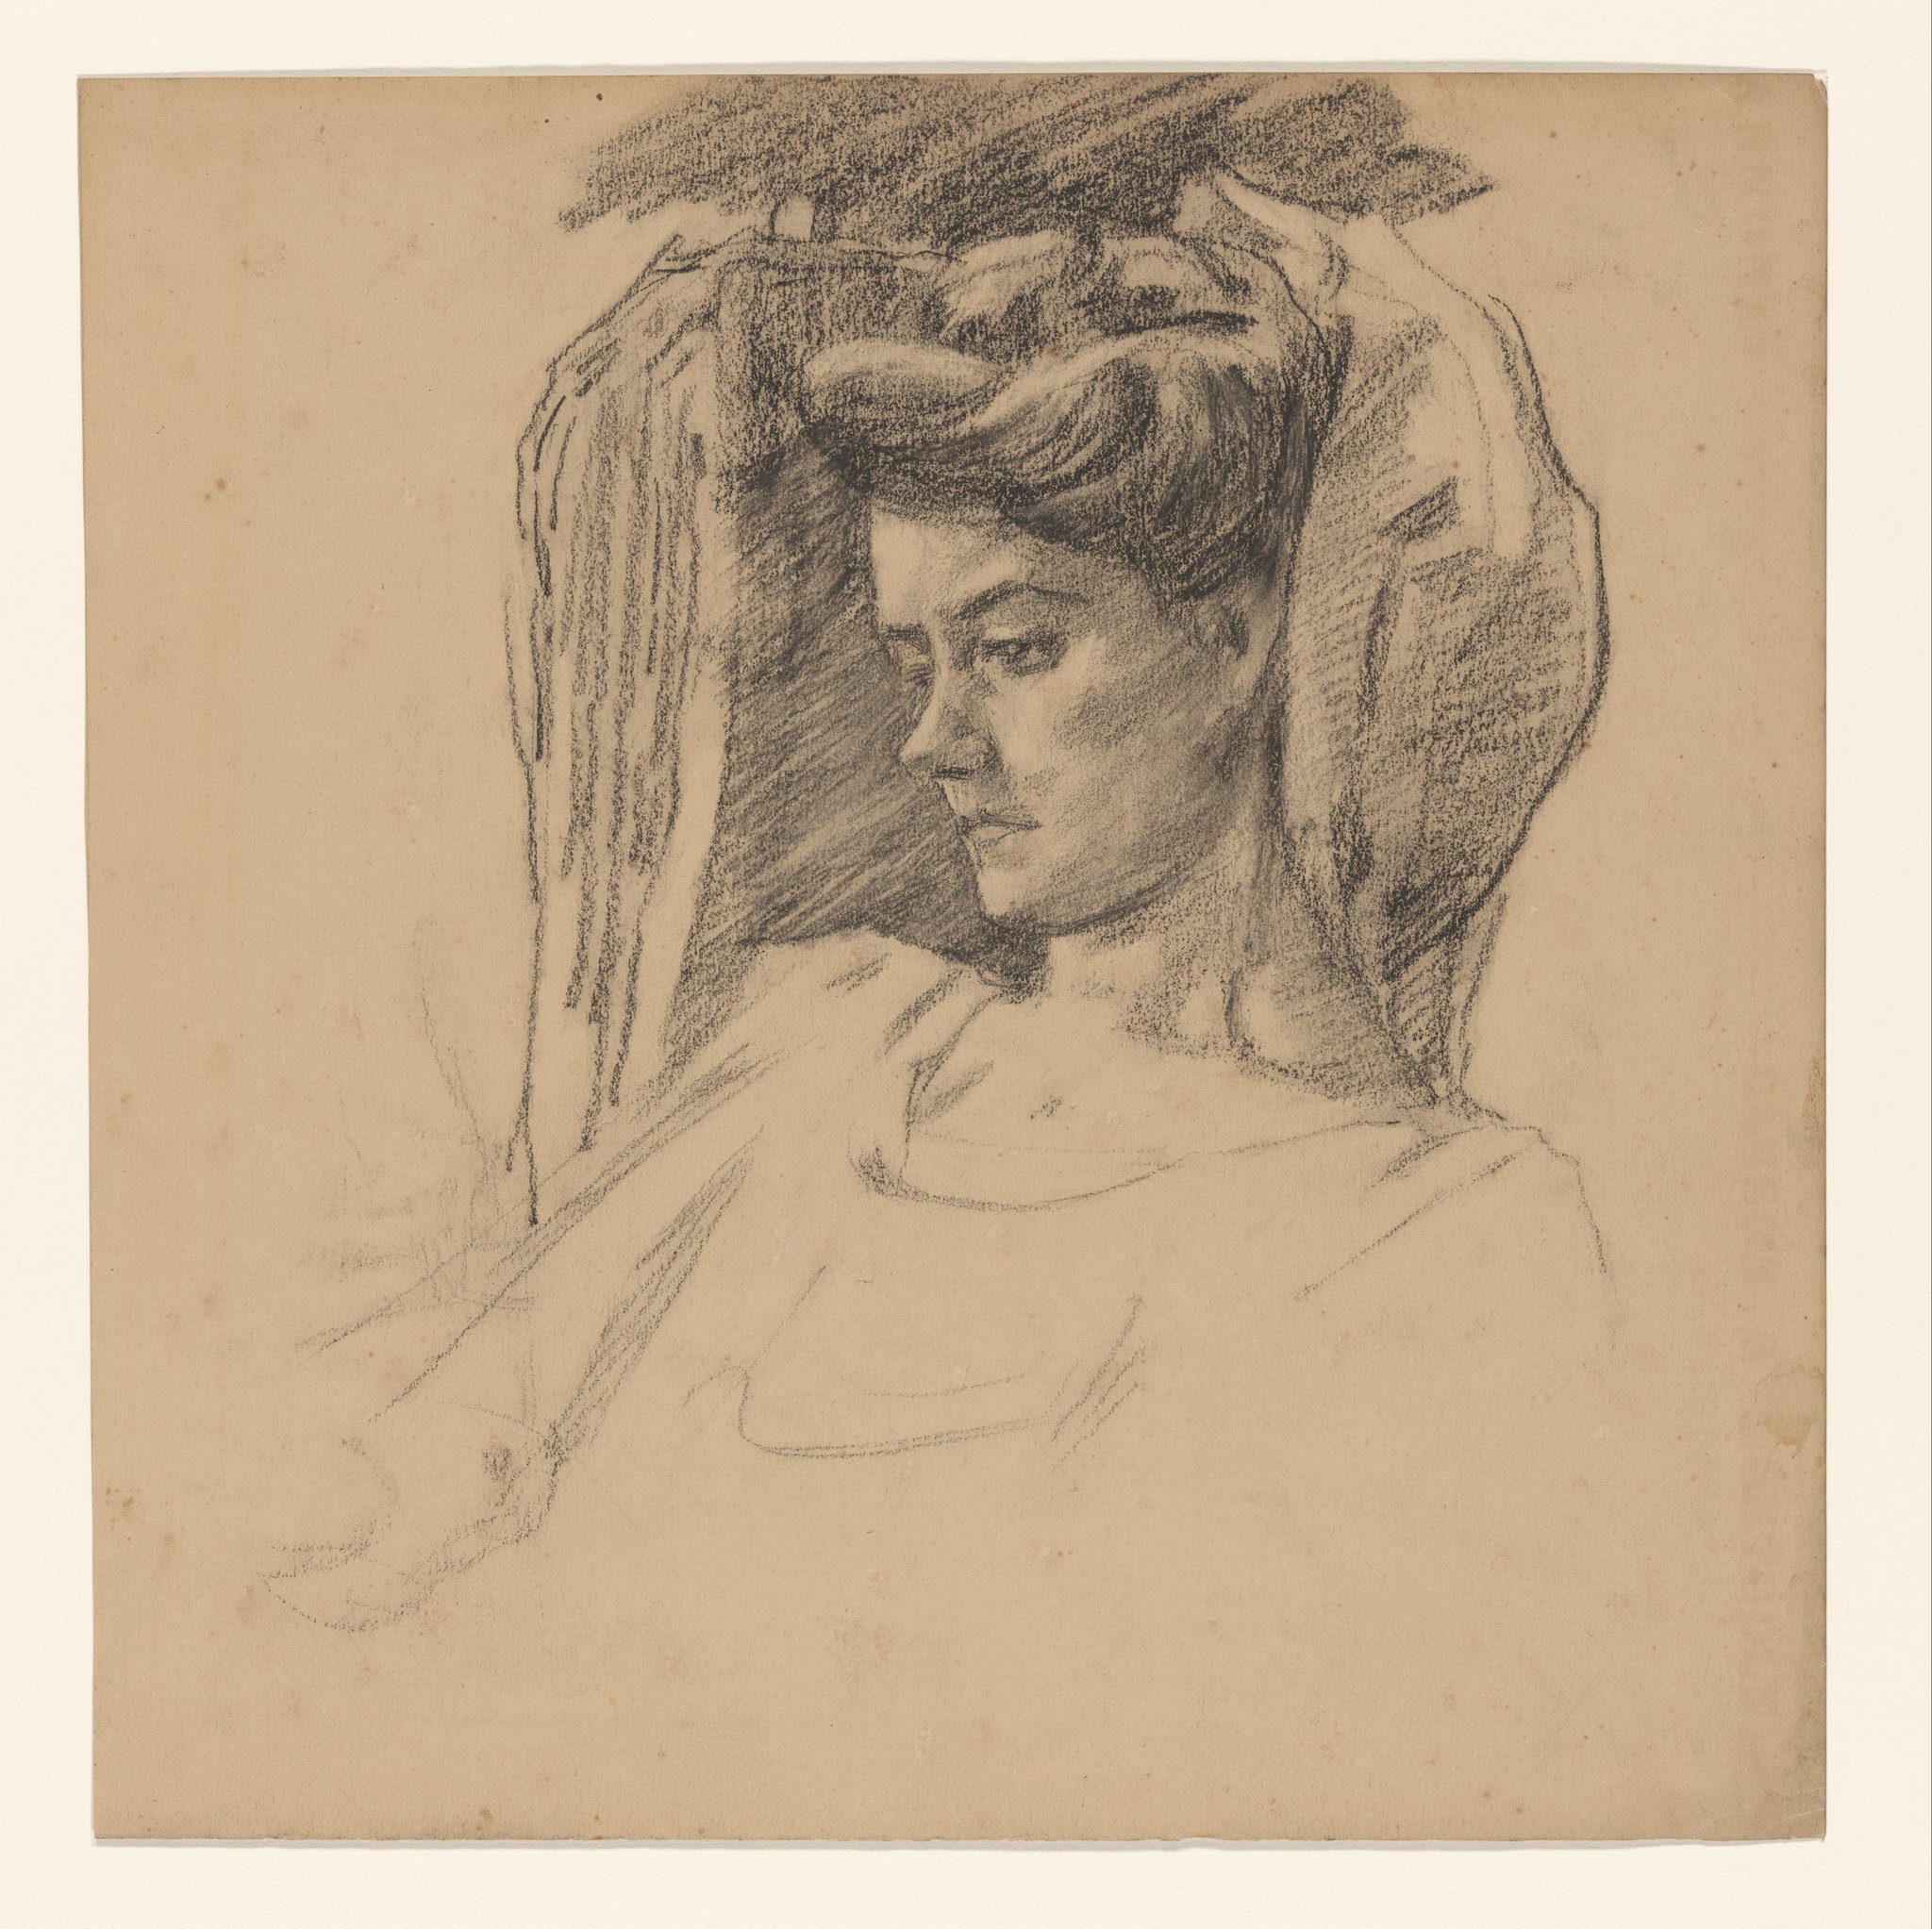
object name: drawing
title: Portret van de vrouw van Wilhelmus Johannes Steenhoff, naar links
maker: wilhelmus johannes steenhoff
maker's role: draughtsman, print maker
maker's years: 1863-1932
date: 1873-1932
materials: chalk, paper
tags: historical persons